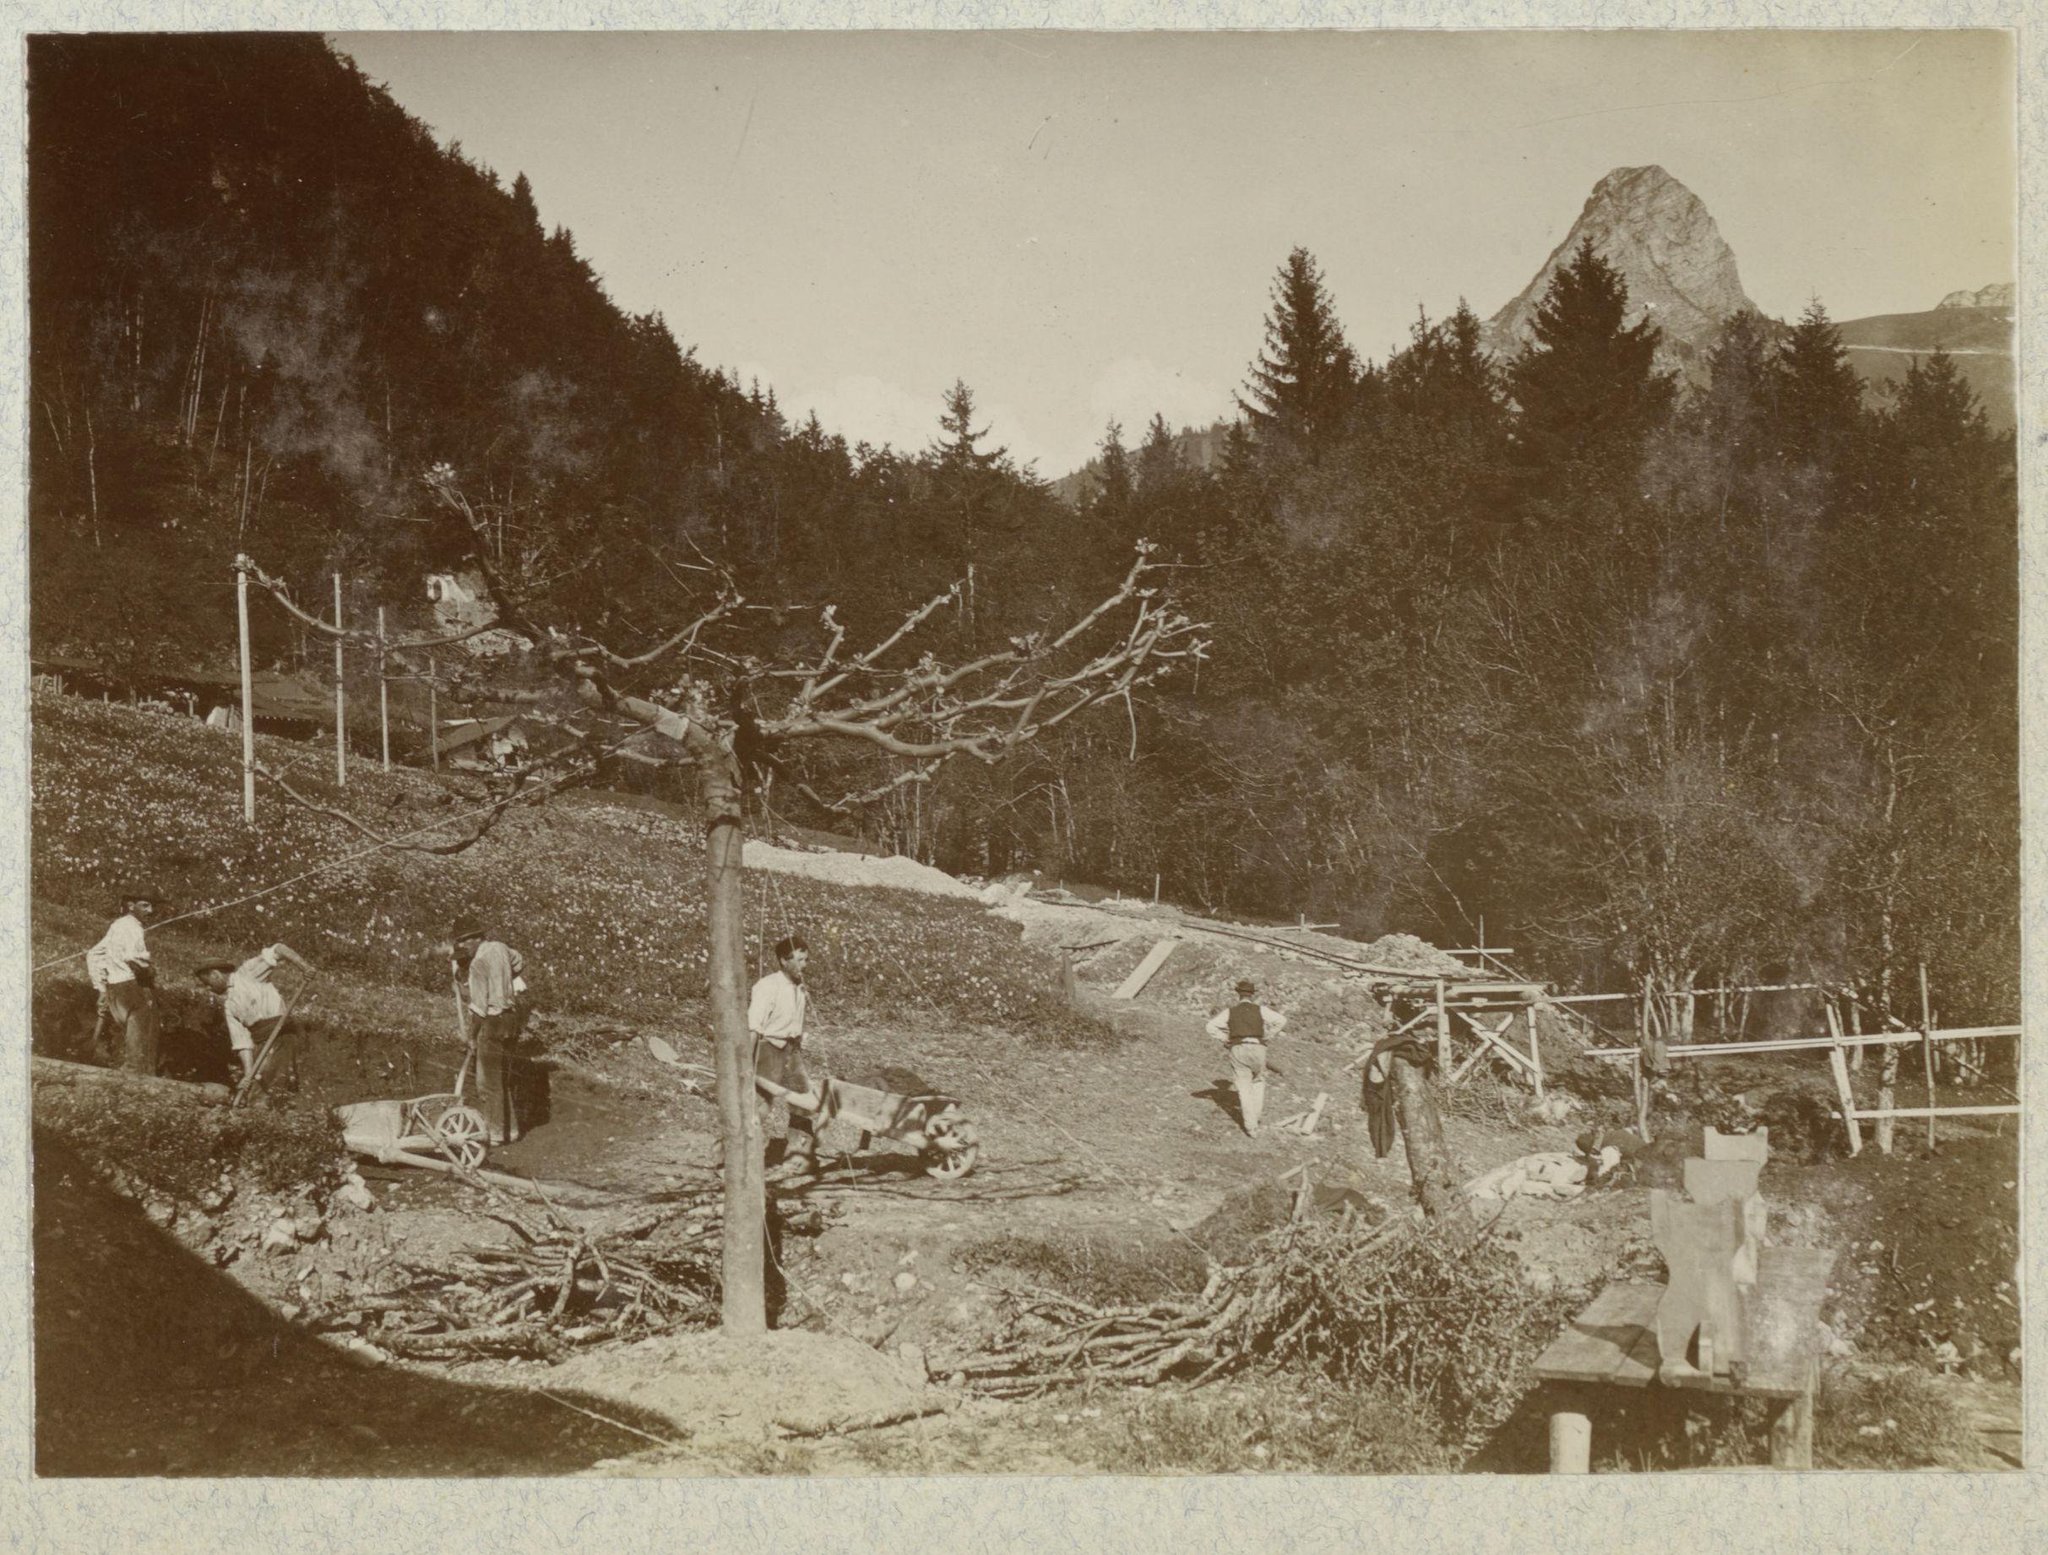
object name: photograph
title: Vakantie in Zwitserland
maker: andries augustus boom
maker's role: amateurfotograaf, handelaar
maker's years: 1878-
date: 1897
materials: photographic support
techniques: photography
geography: switzerland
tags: amsterdam, andries augustus boom, switzerland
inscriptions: date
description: Vakantie in Vitznau, Zwitserland. Onderdeel van het fotoalbum van de familie Boom-Gonggrijp in Suriname en Curaçao.